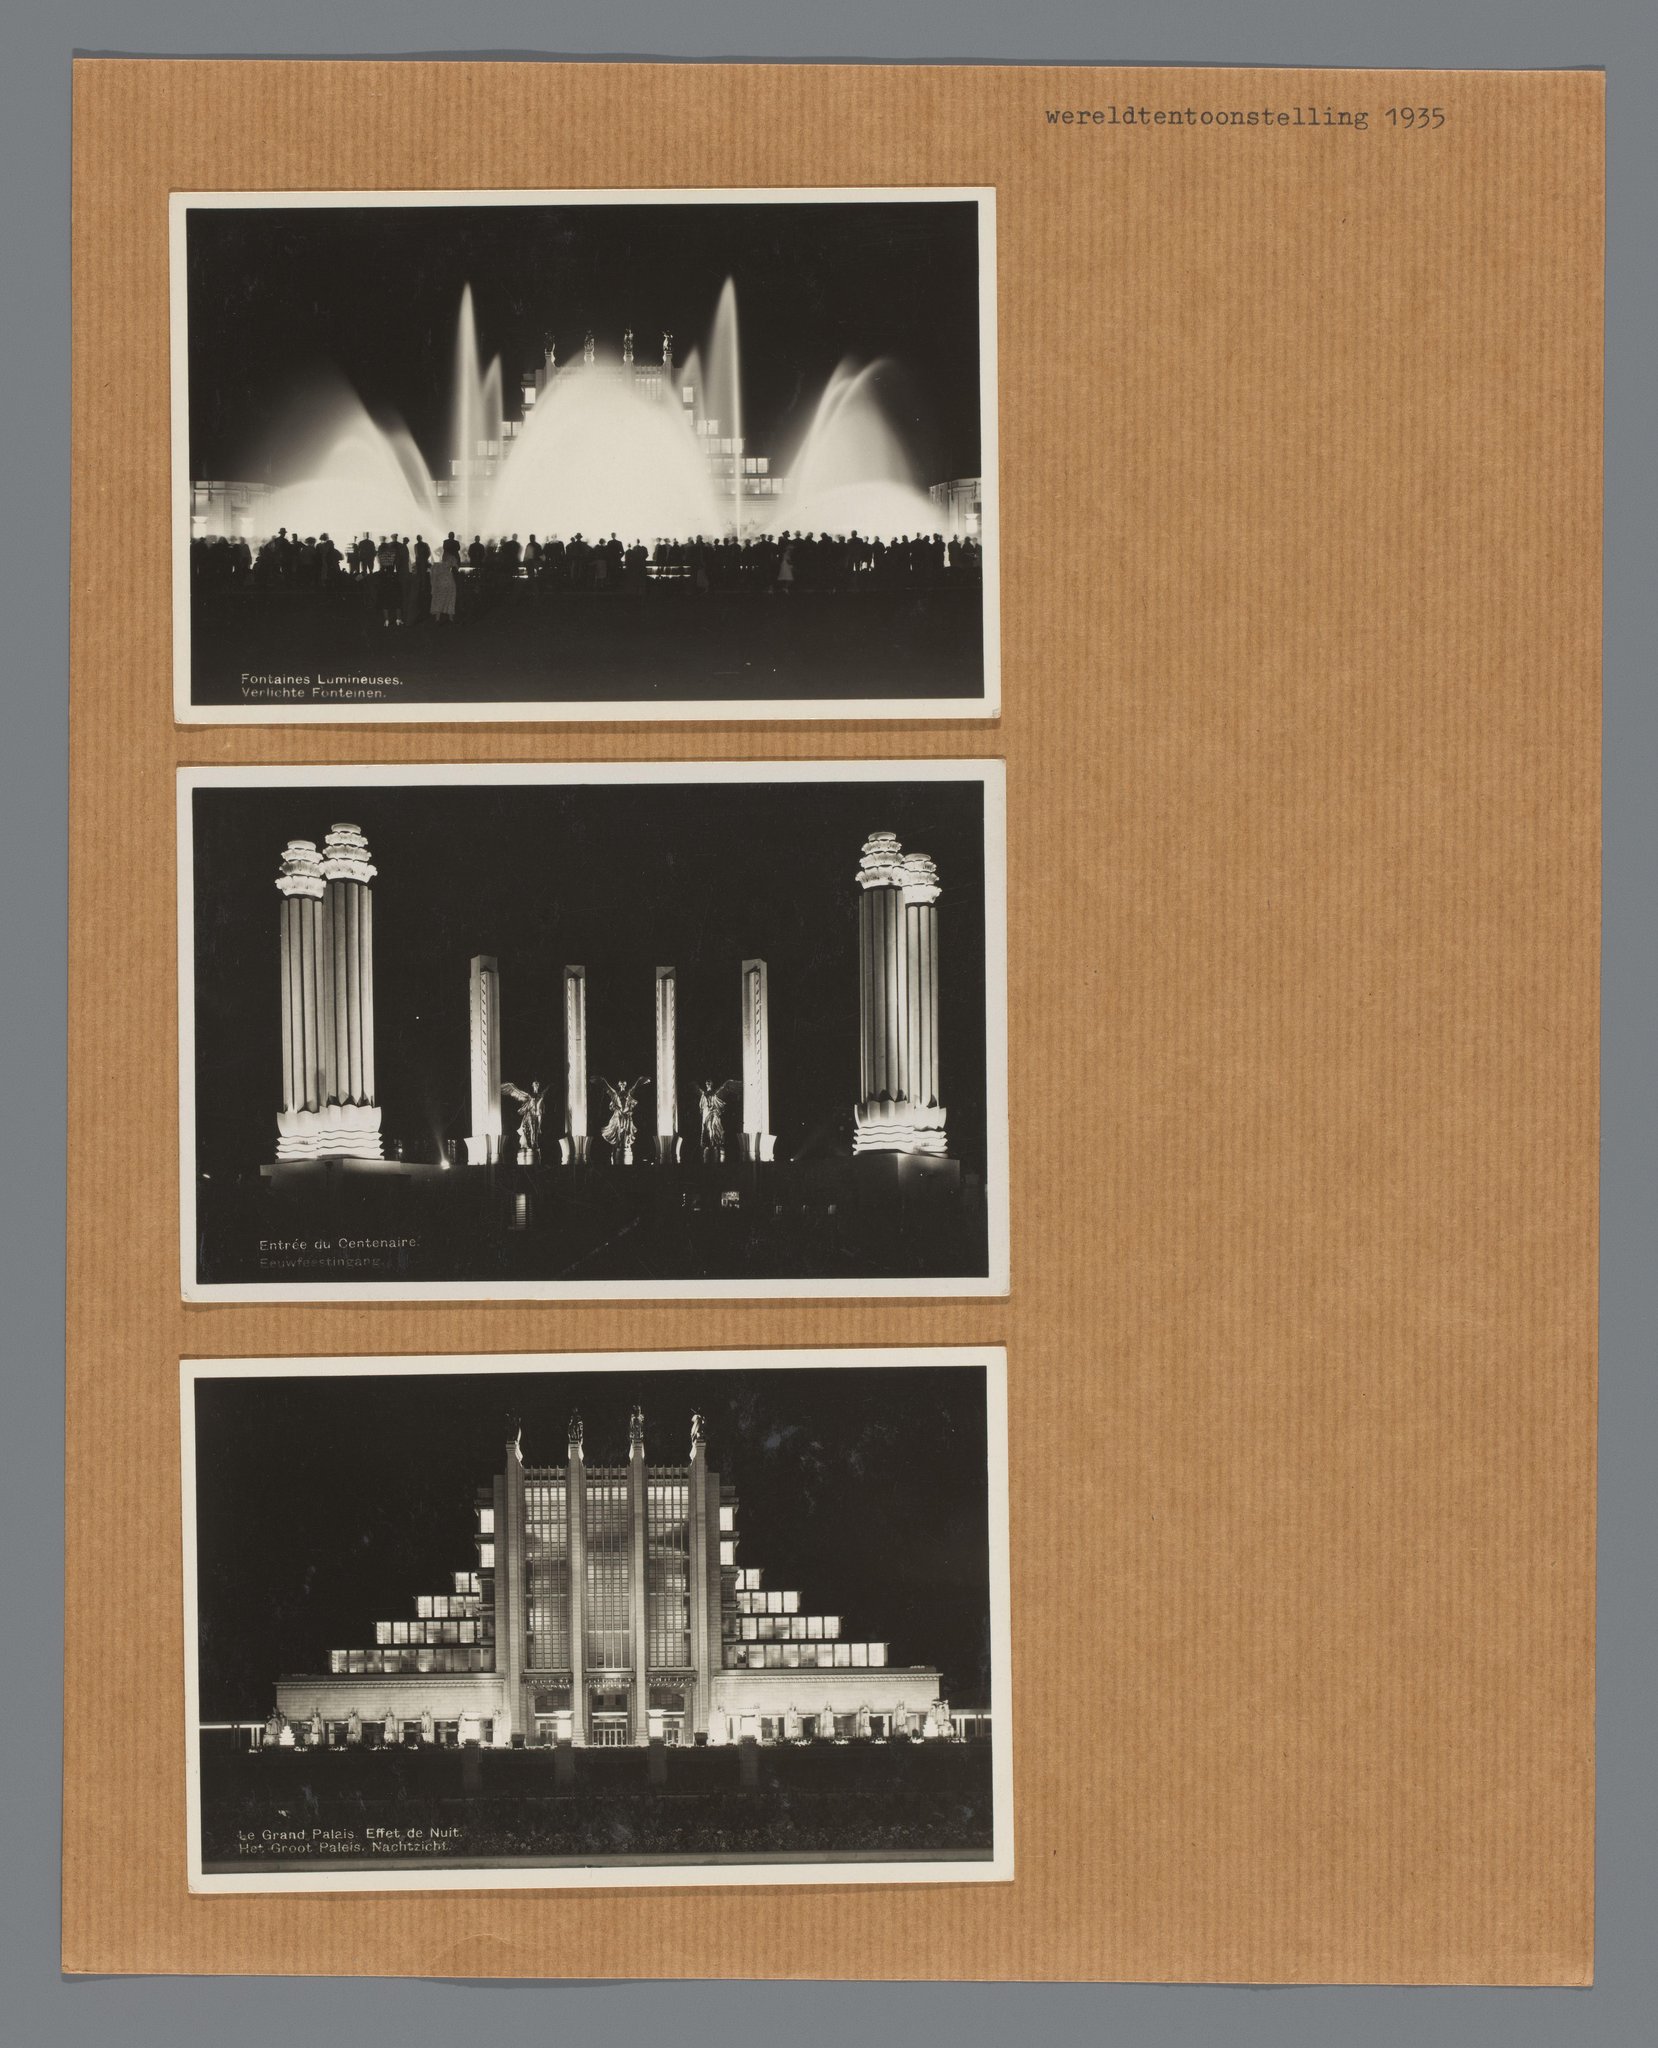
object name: photograph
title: Wereldtentoonstelling Brussels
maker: Anonymous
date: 1935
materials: photographic support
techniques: gelatin silver print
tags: brussels